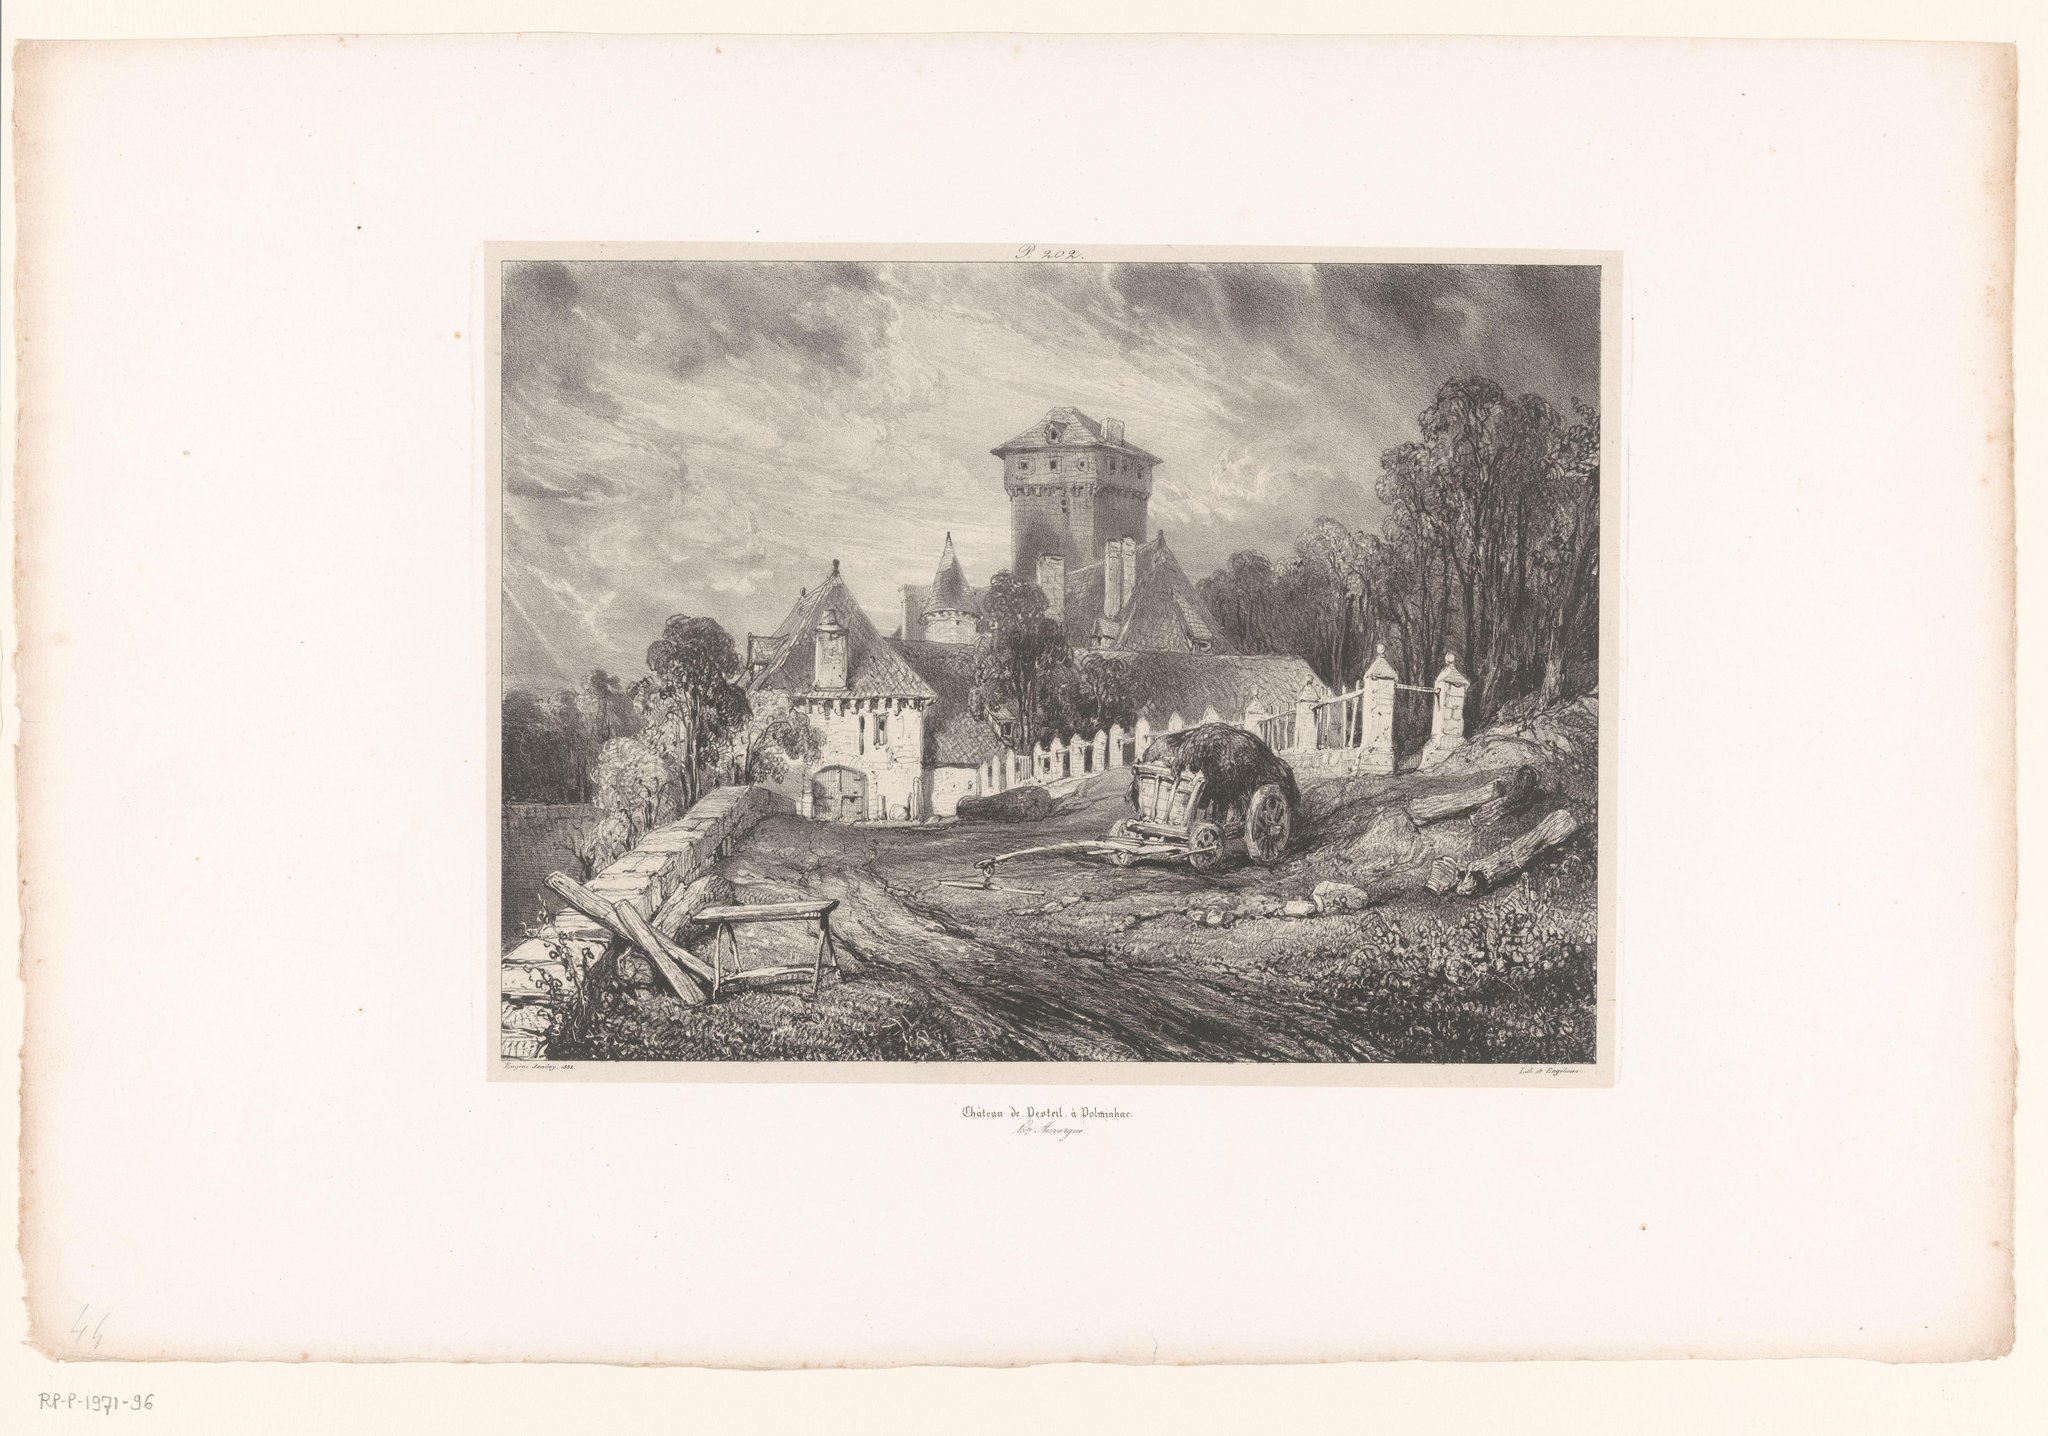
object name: book illustration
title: Château de Pesteil à Polminhac, H.te Auvergne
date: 1832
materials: paper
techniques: lithograph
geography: paris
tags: castle, landscape with tower or castle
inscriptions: collector's mark: Lugt 2228a, collector's mark: Lugt 2760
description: Prent gebruikt voor: Nodier, Ch. en Taylor, I. Voyages pittoresques et romantiques dans l'ancienne France. Auvergne. Parijs: Casimir Gide, 1829-1833. dl. 1, p. 202.